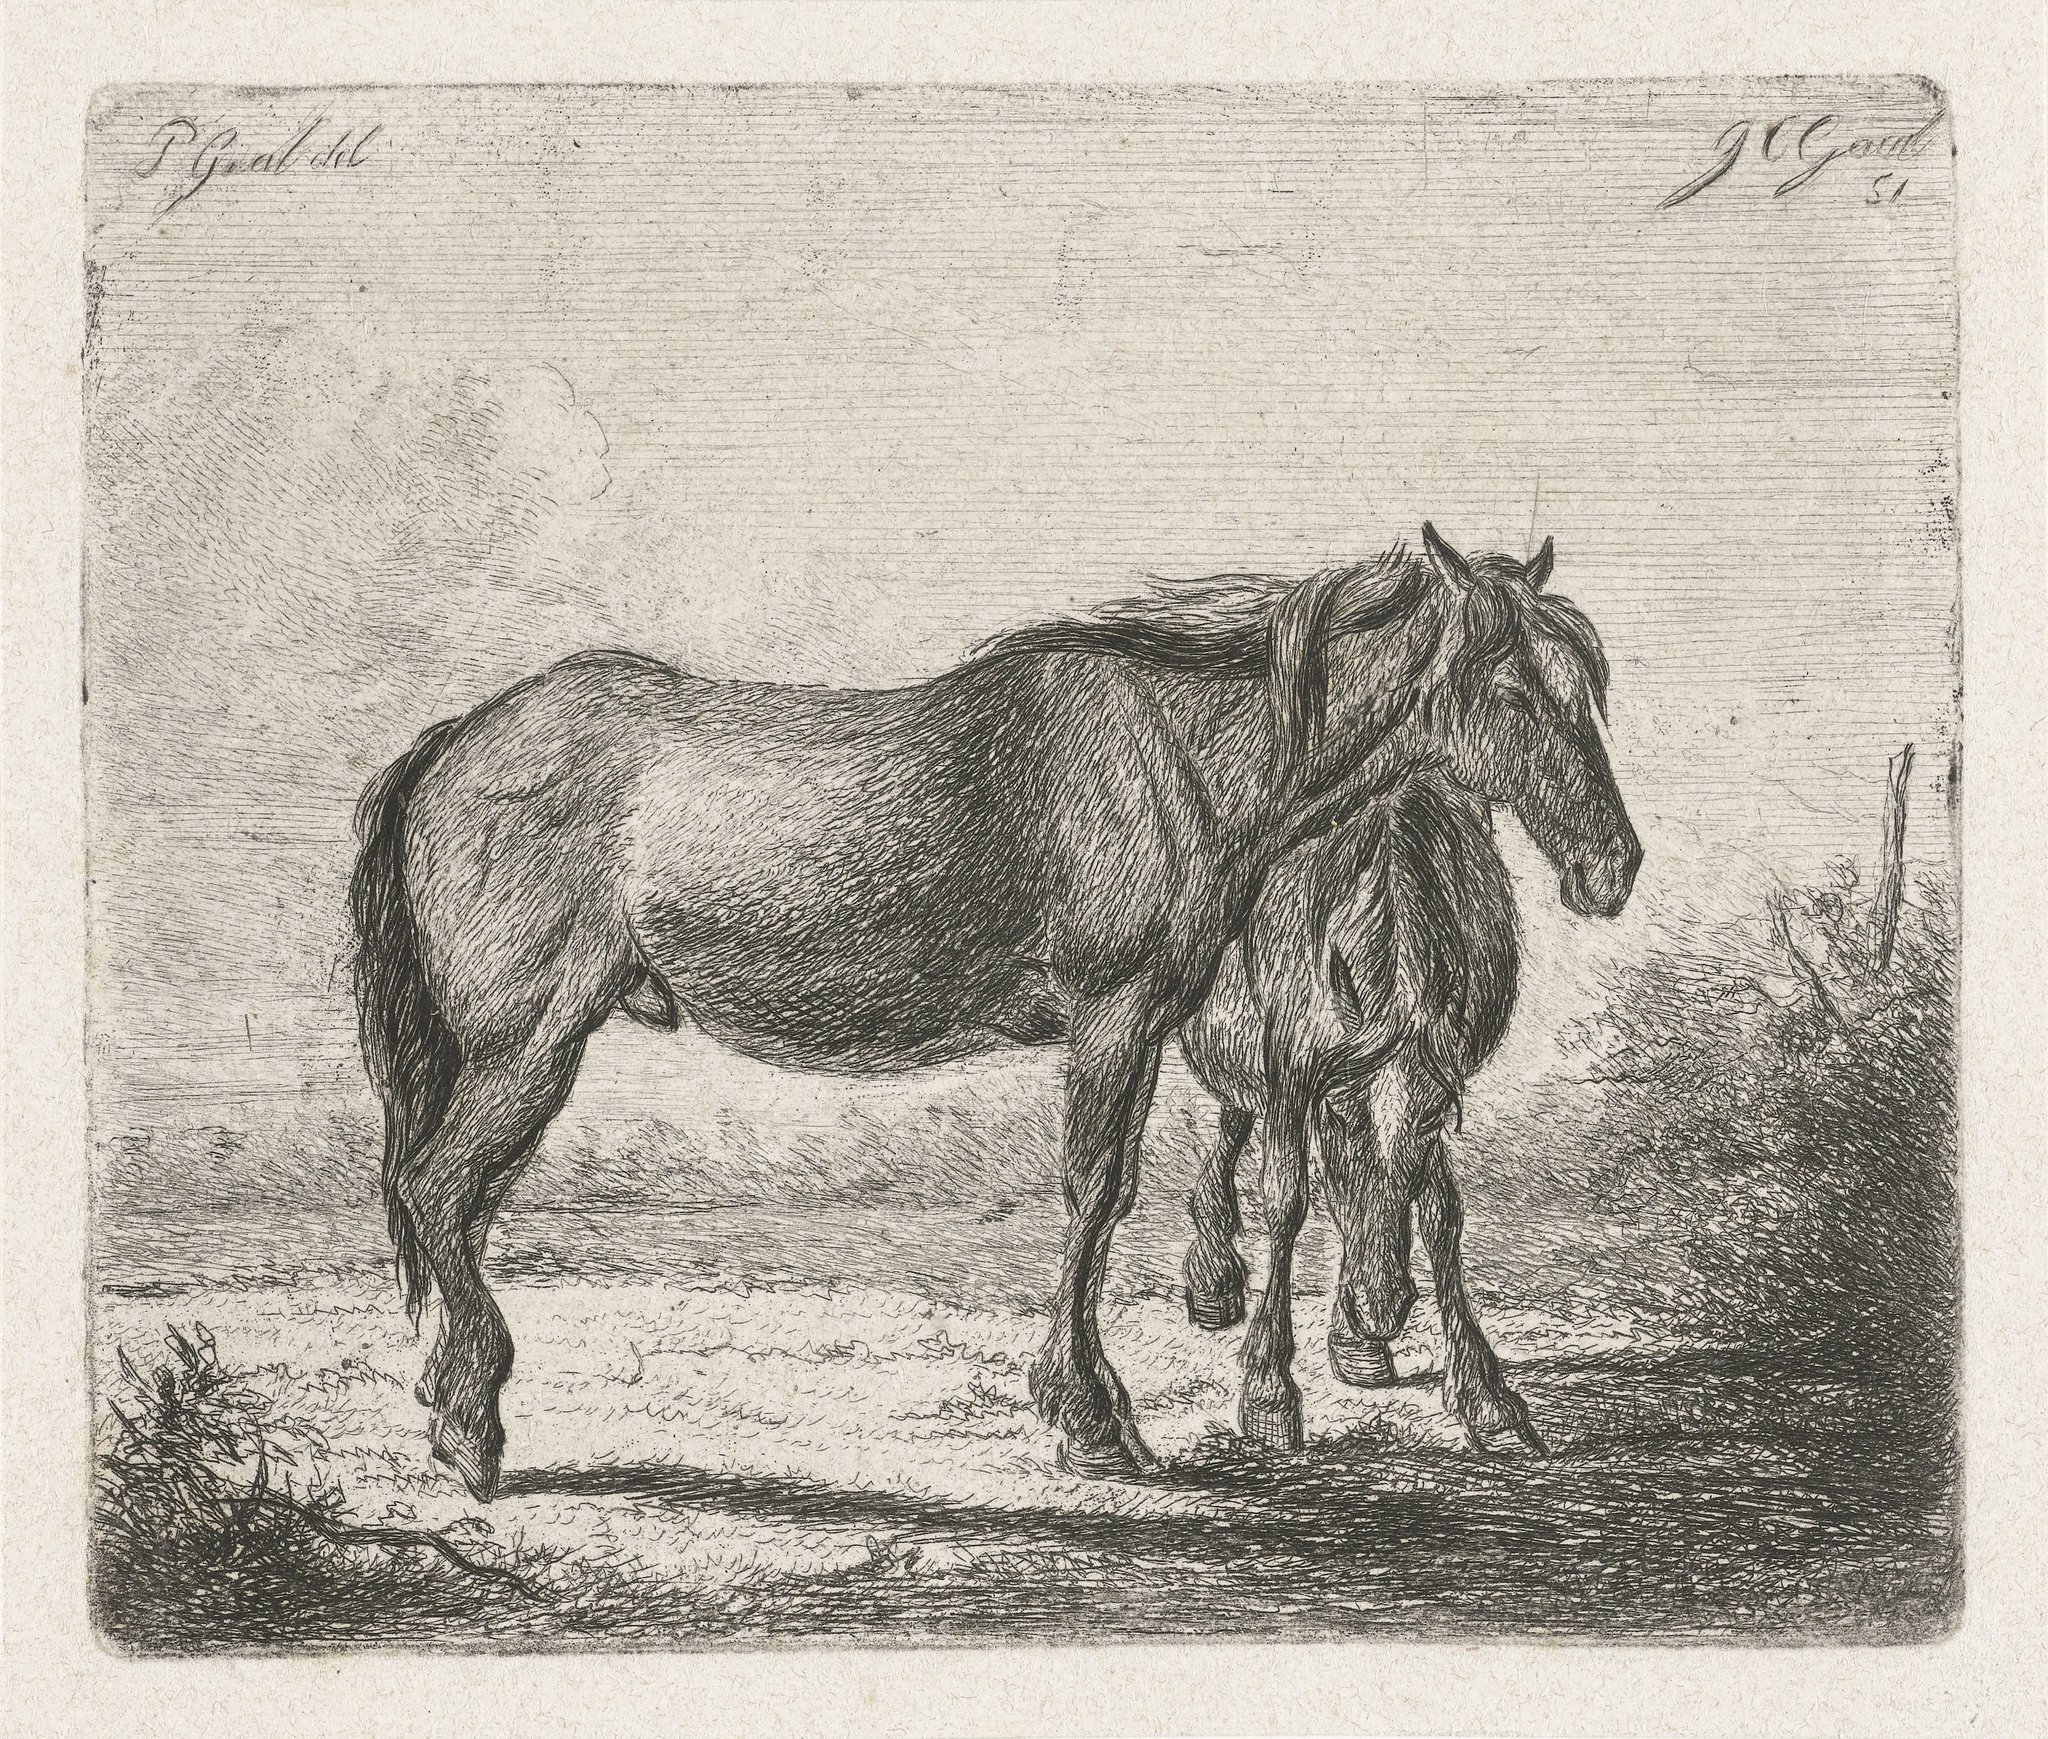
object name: print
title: Twee paarden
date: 1851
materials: paper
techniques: etching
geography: netherlands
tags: horse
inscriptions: collector's mark: Lugt 2228